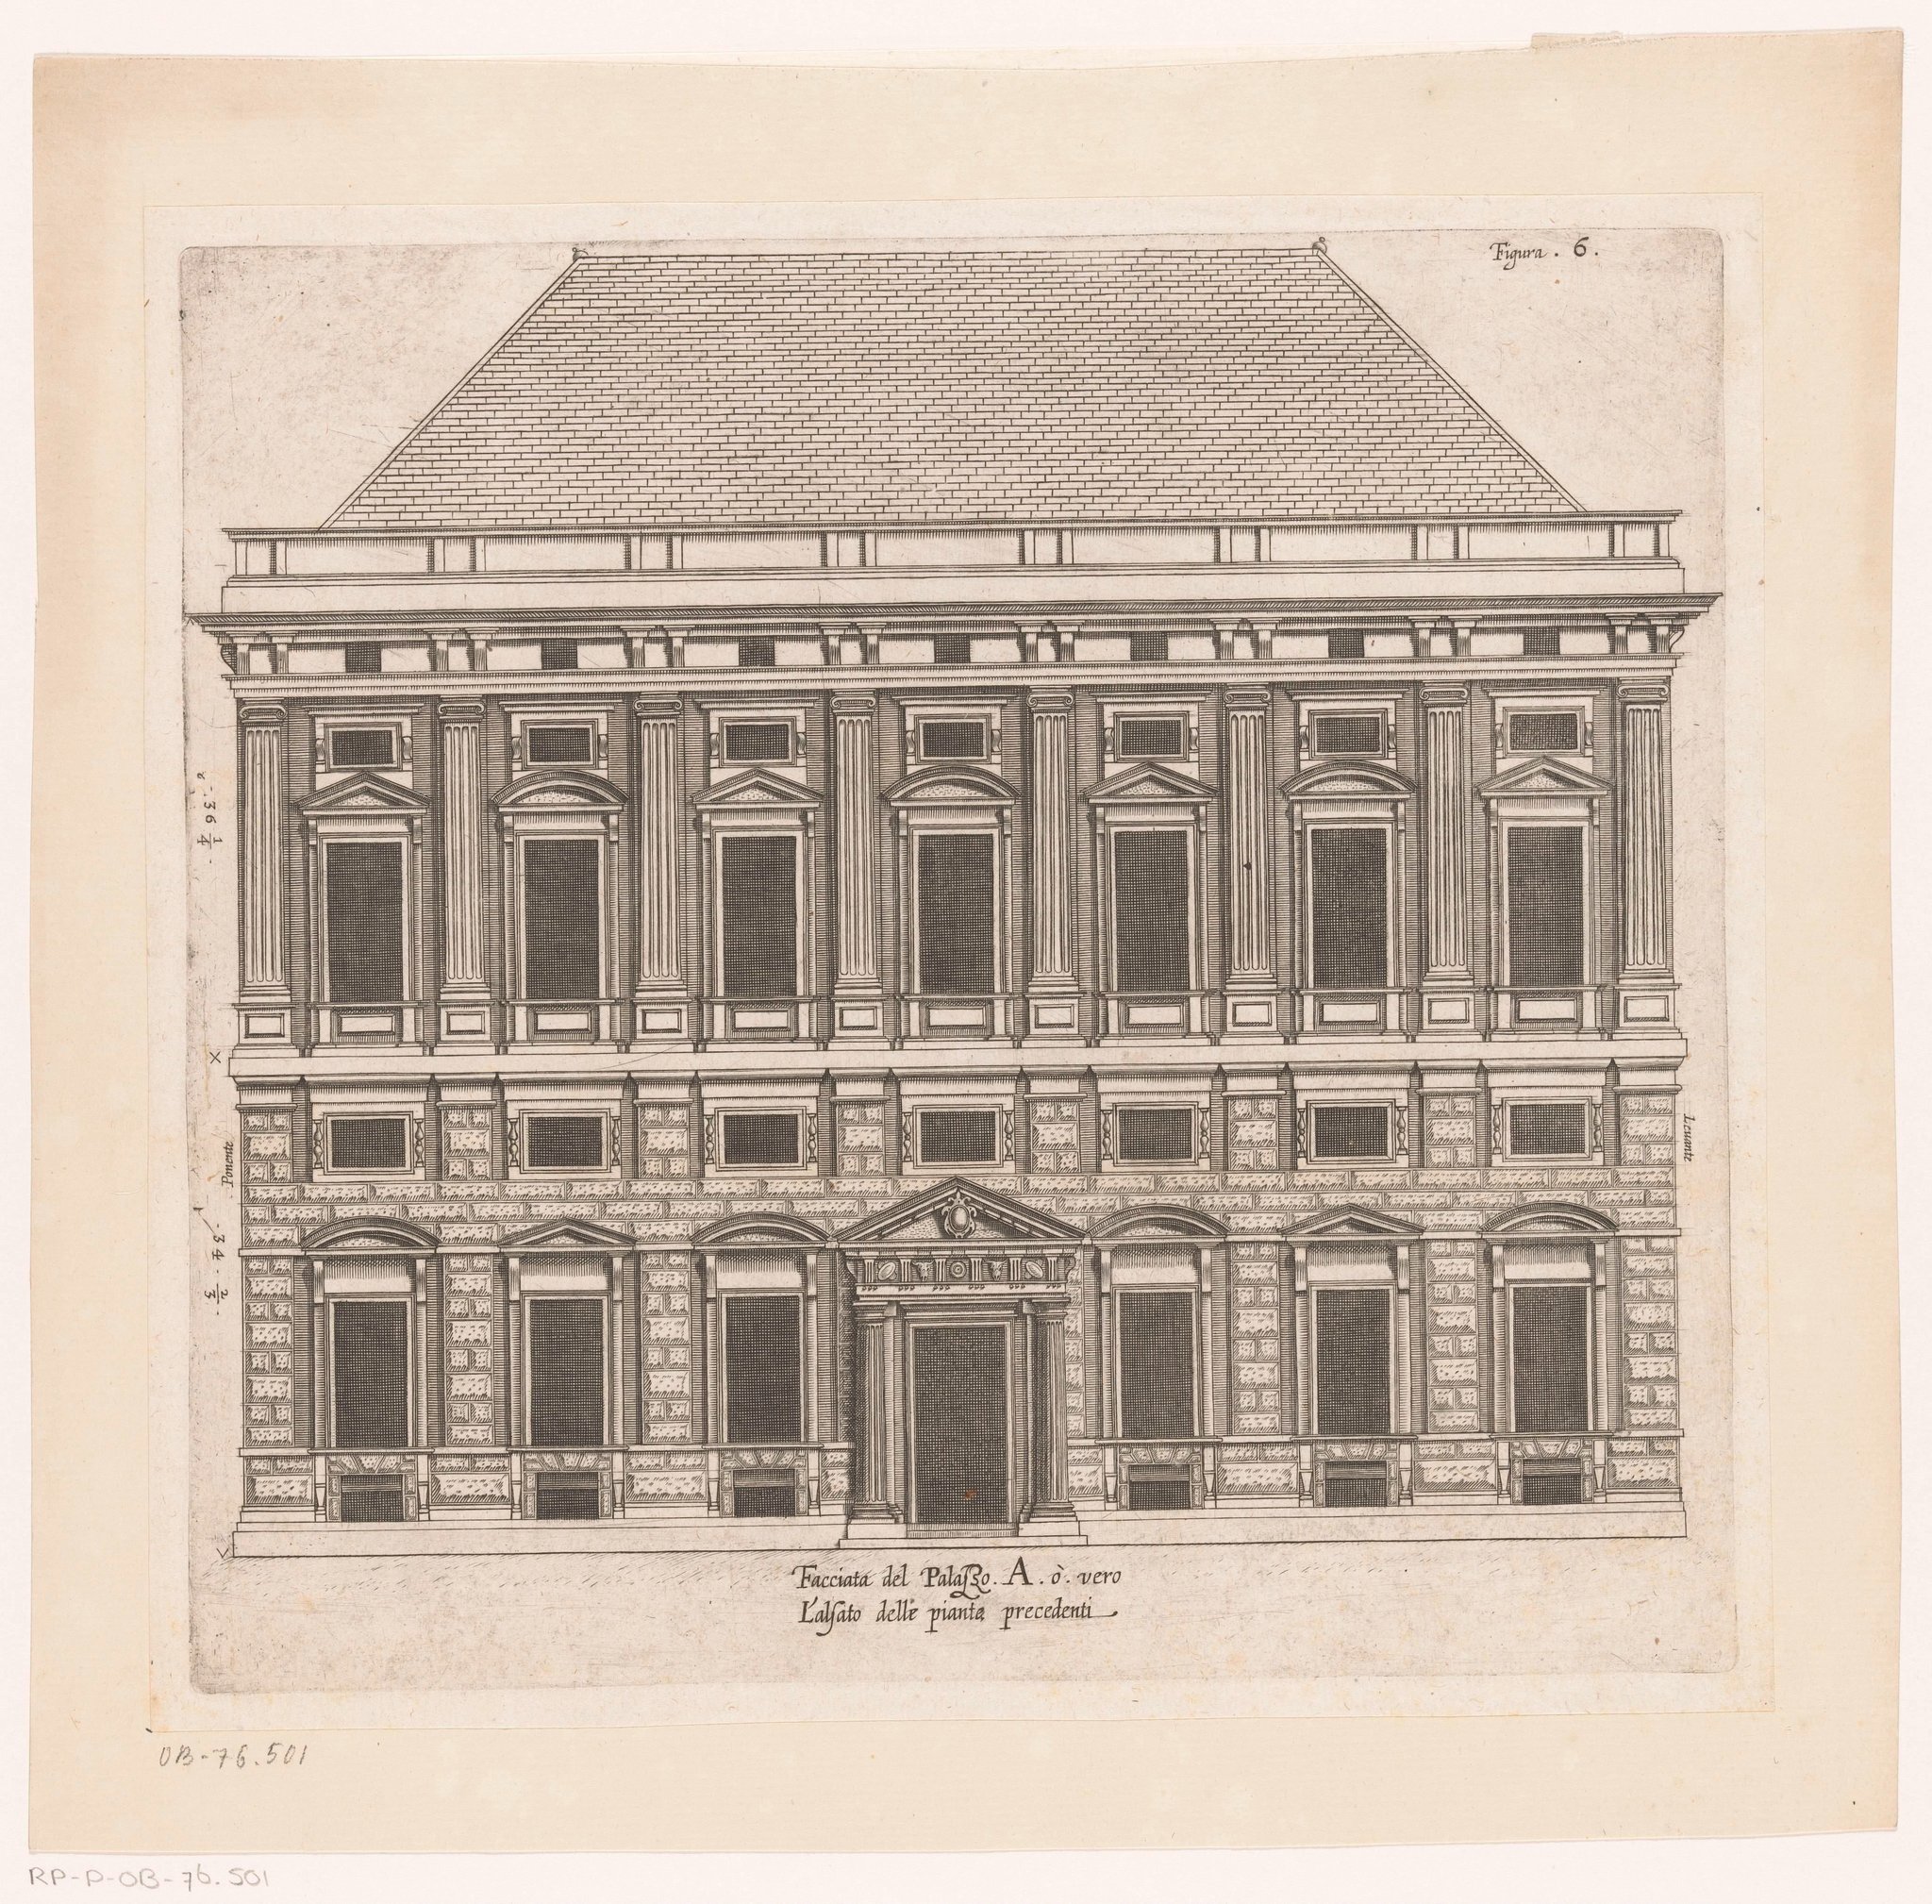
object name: print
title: Opstand van de façade van het Palazzo Carrega-Cataldi te Genua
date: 1622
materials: paper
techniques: engraving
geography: antwerp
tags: exterior ~ architectural design or model, front façade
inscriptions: collector's mark: Lugt 240